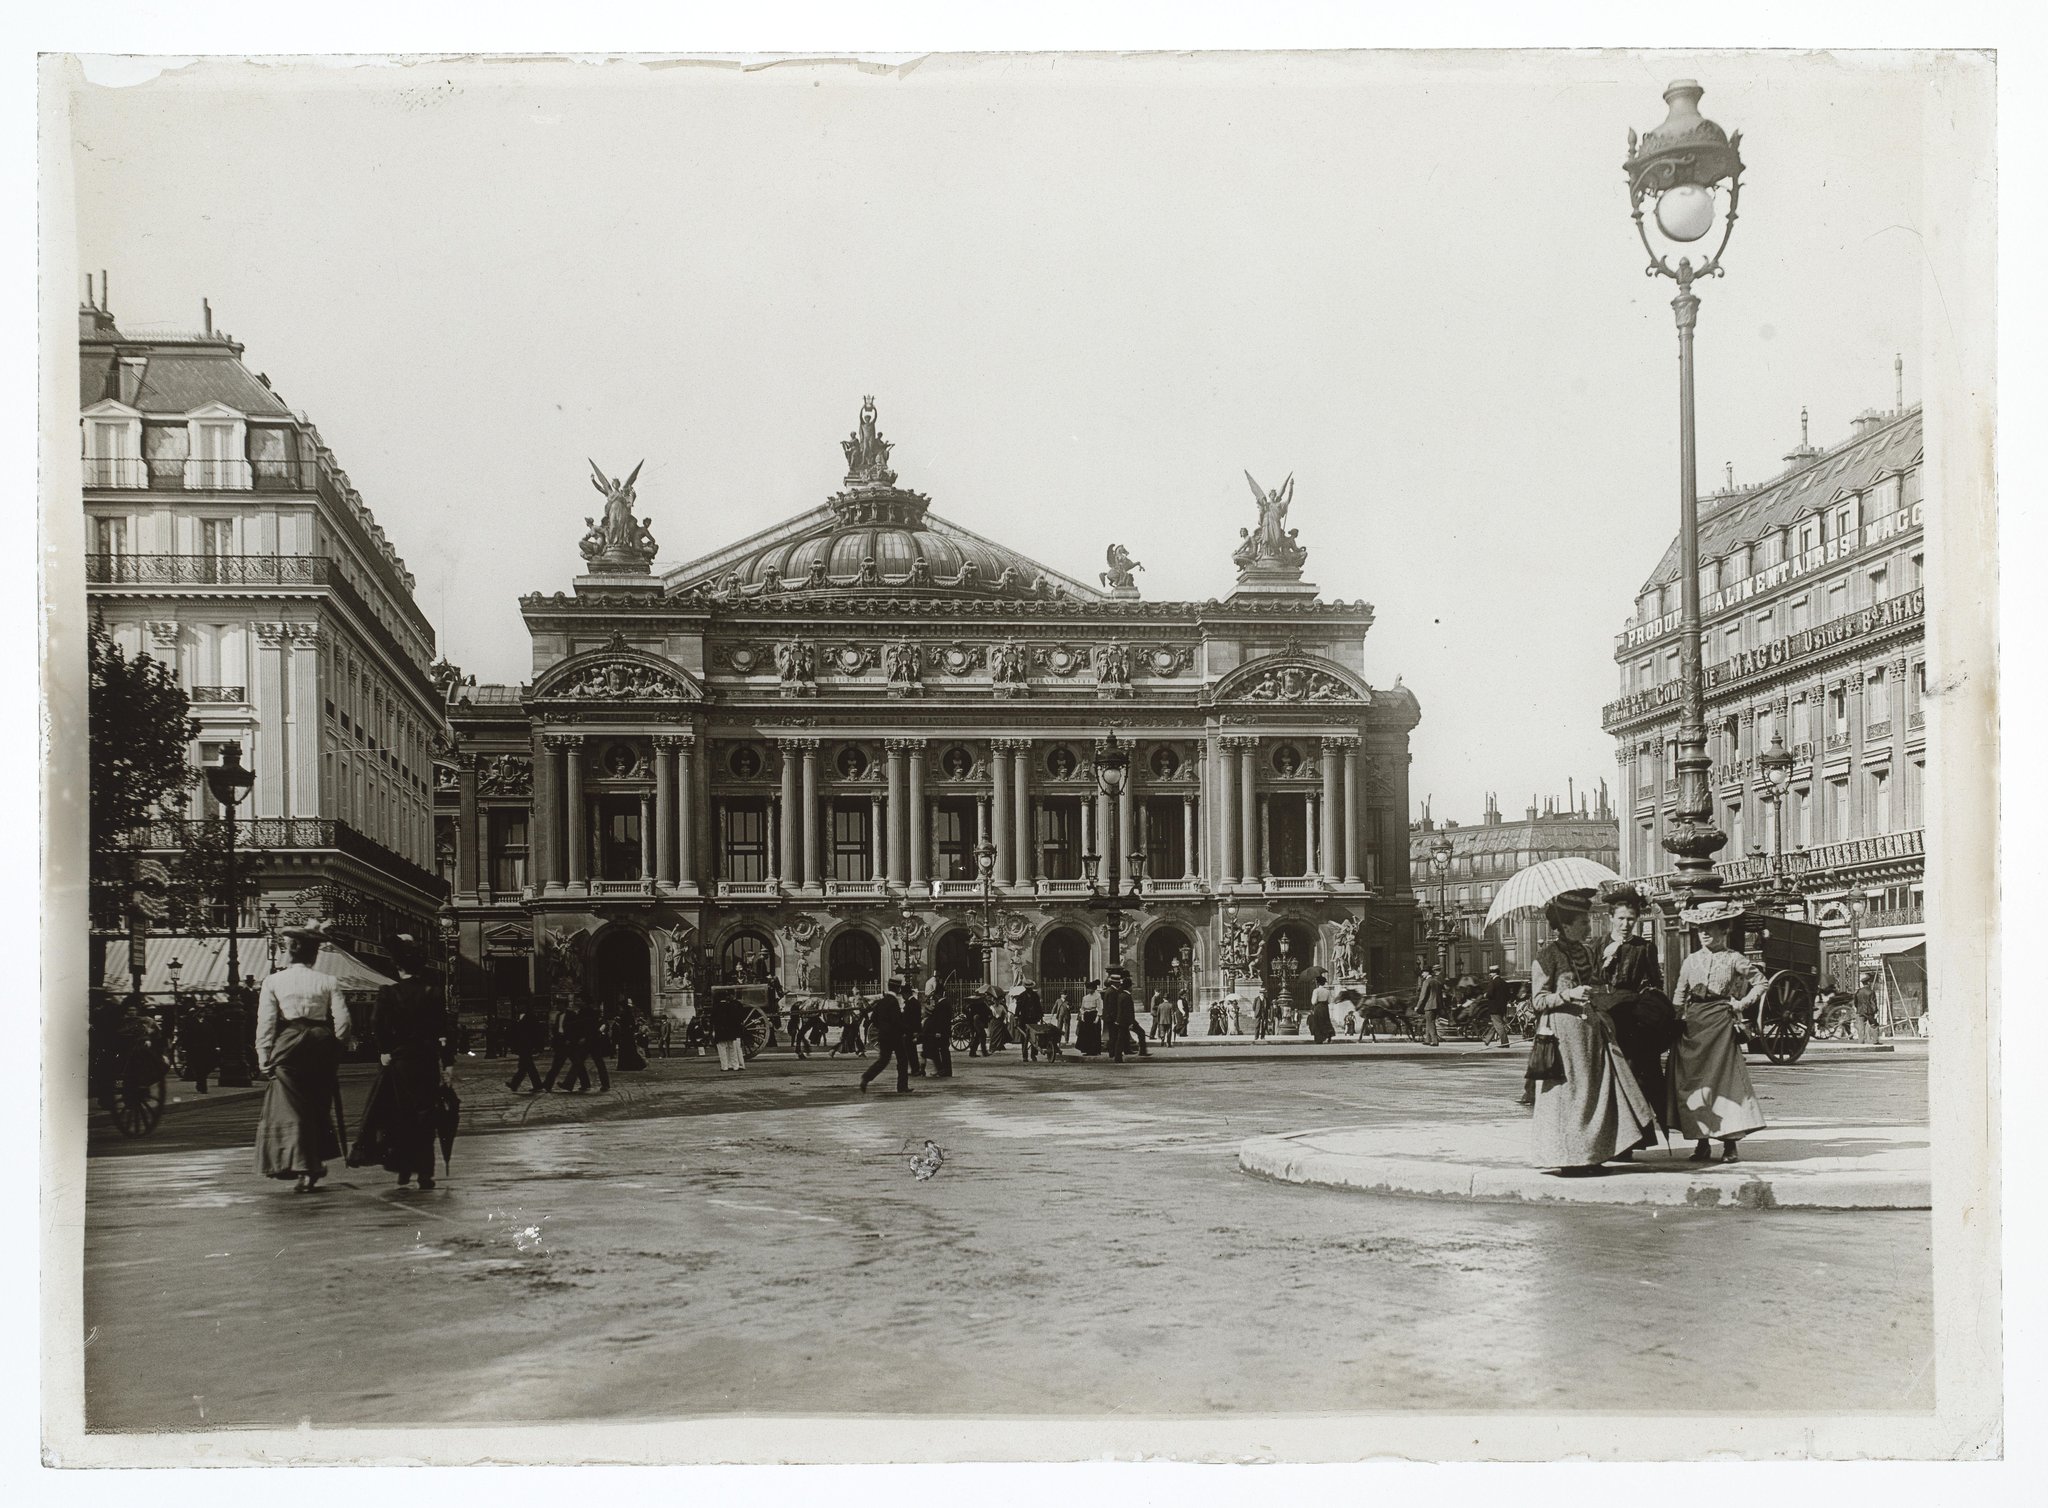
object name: photograph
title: Gezicht op de Opéra Garnier te Parijs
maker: Anonymous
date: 1880-1900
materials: glass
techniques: collodion process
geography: paris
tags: portrait of a musician